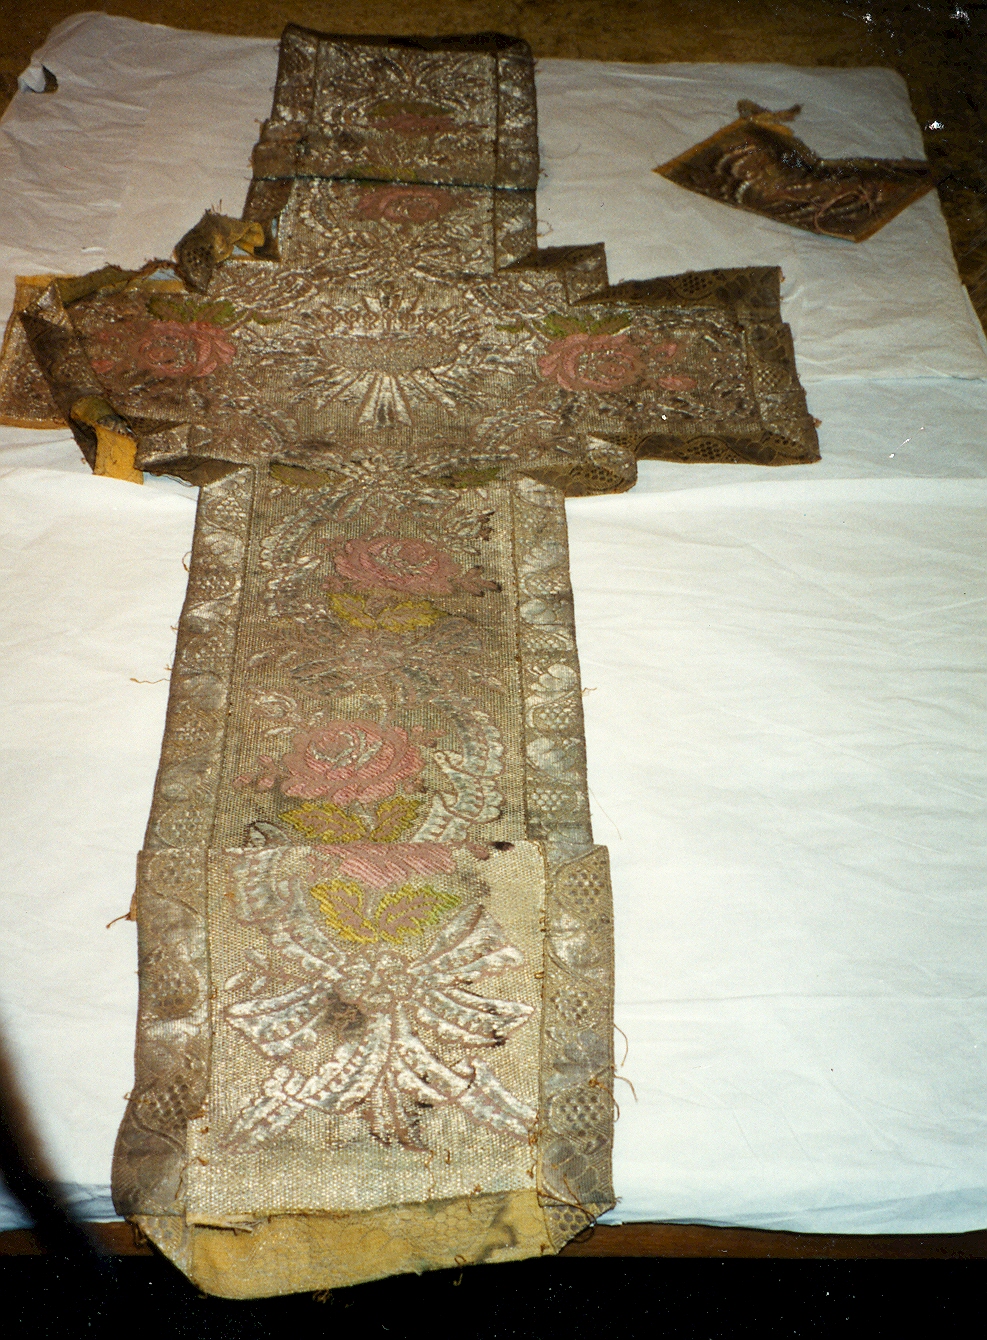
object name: orphrey, runner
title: Two Orphrey Sections made into a runner; Top of an Orphrey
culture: italian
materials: cotton, metal, silk